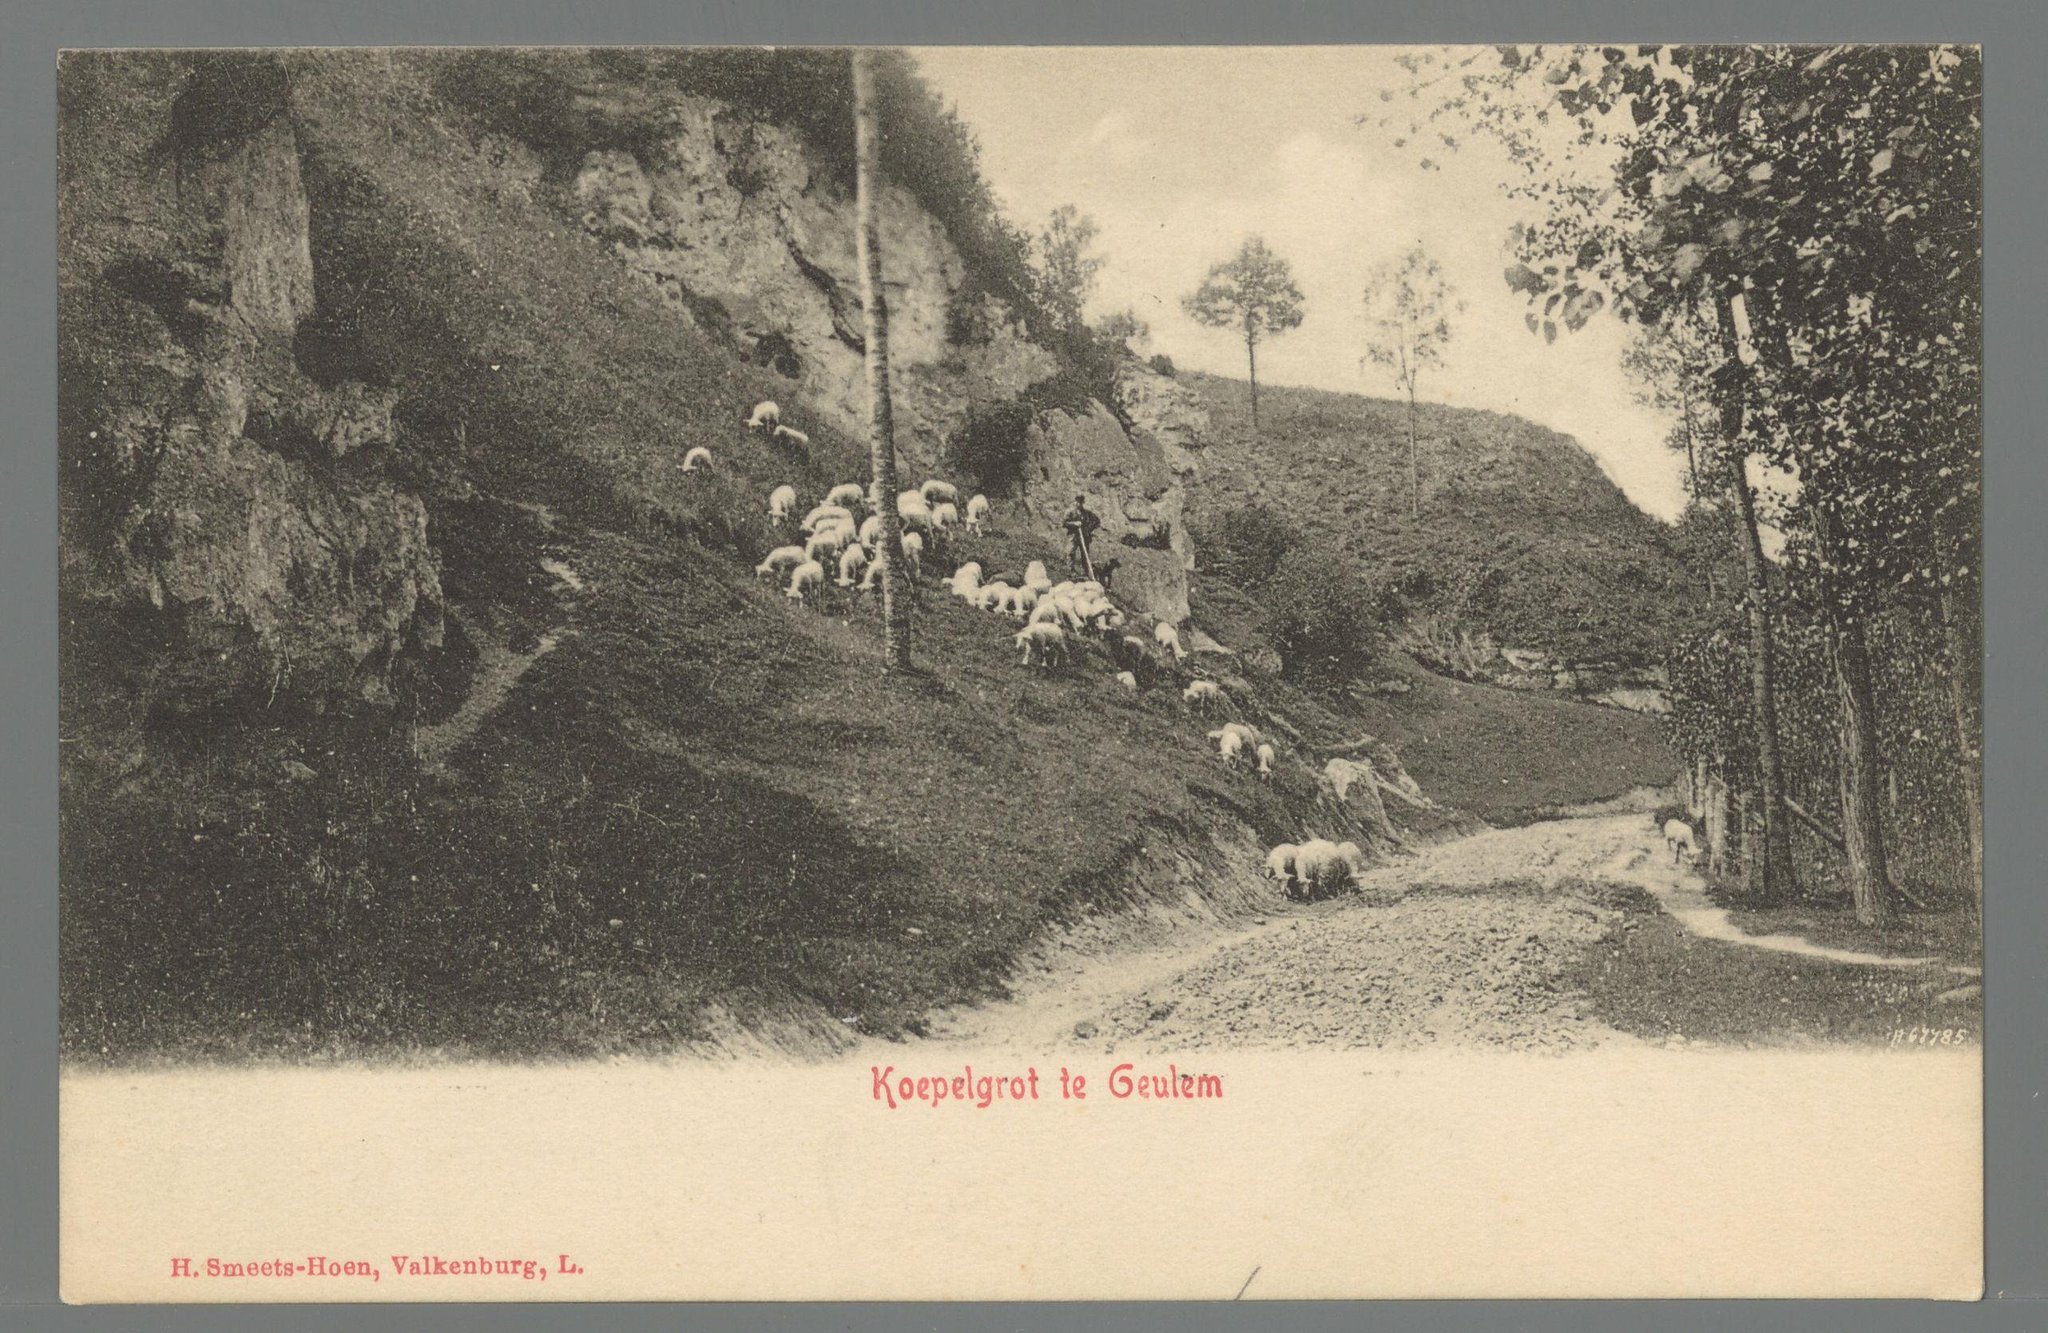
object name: ansichtkaart, prentbriefkaart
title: Koepelgrot te Geulem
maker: Anonymous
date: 1905-1930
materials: cardboard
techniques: photograph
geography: geulhem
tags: cave, grotto, herd, flock